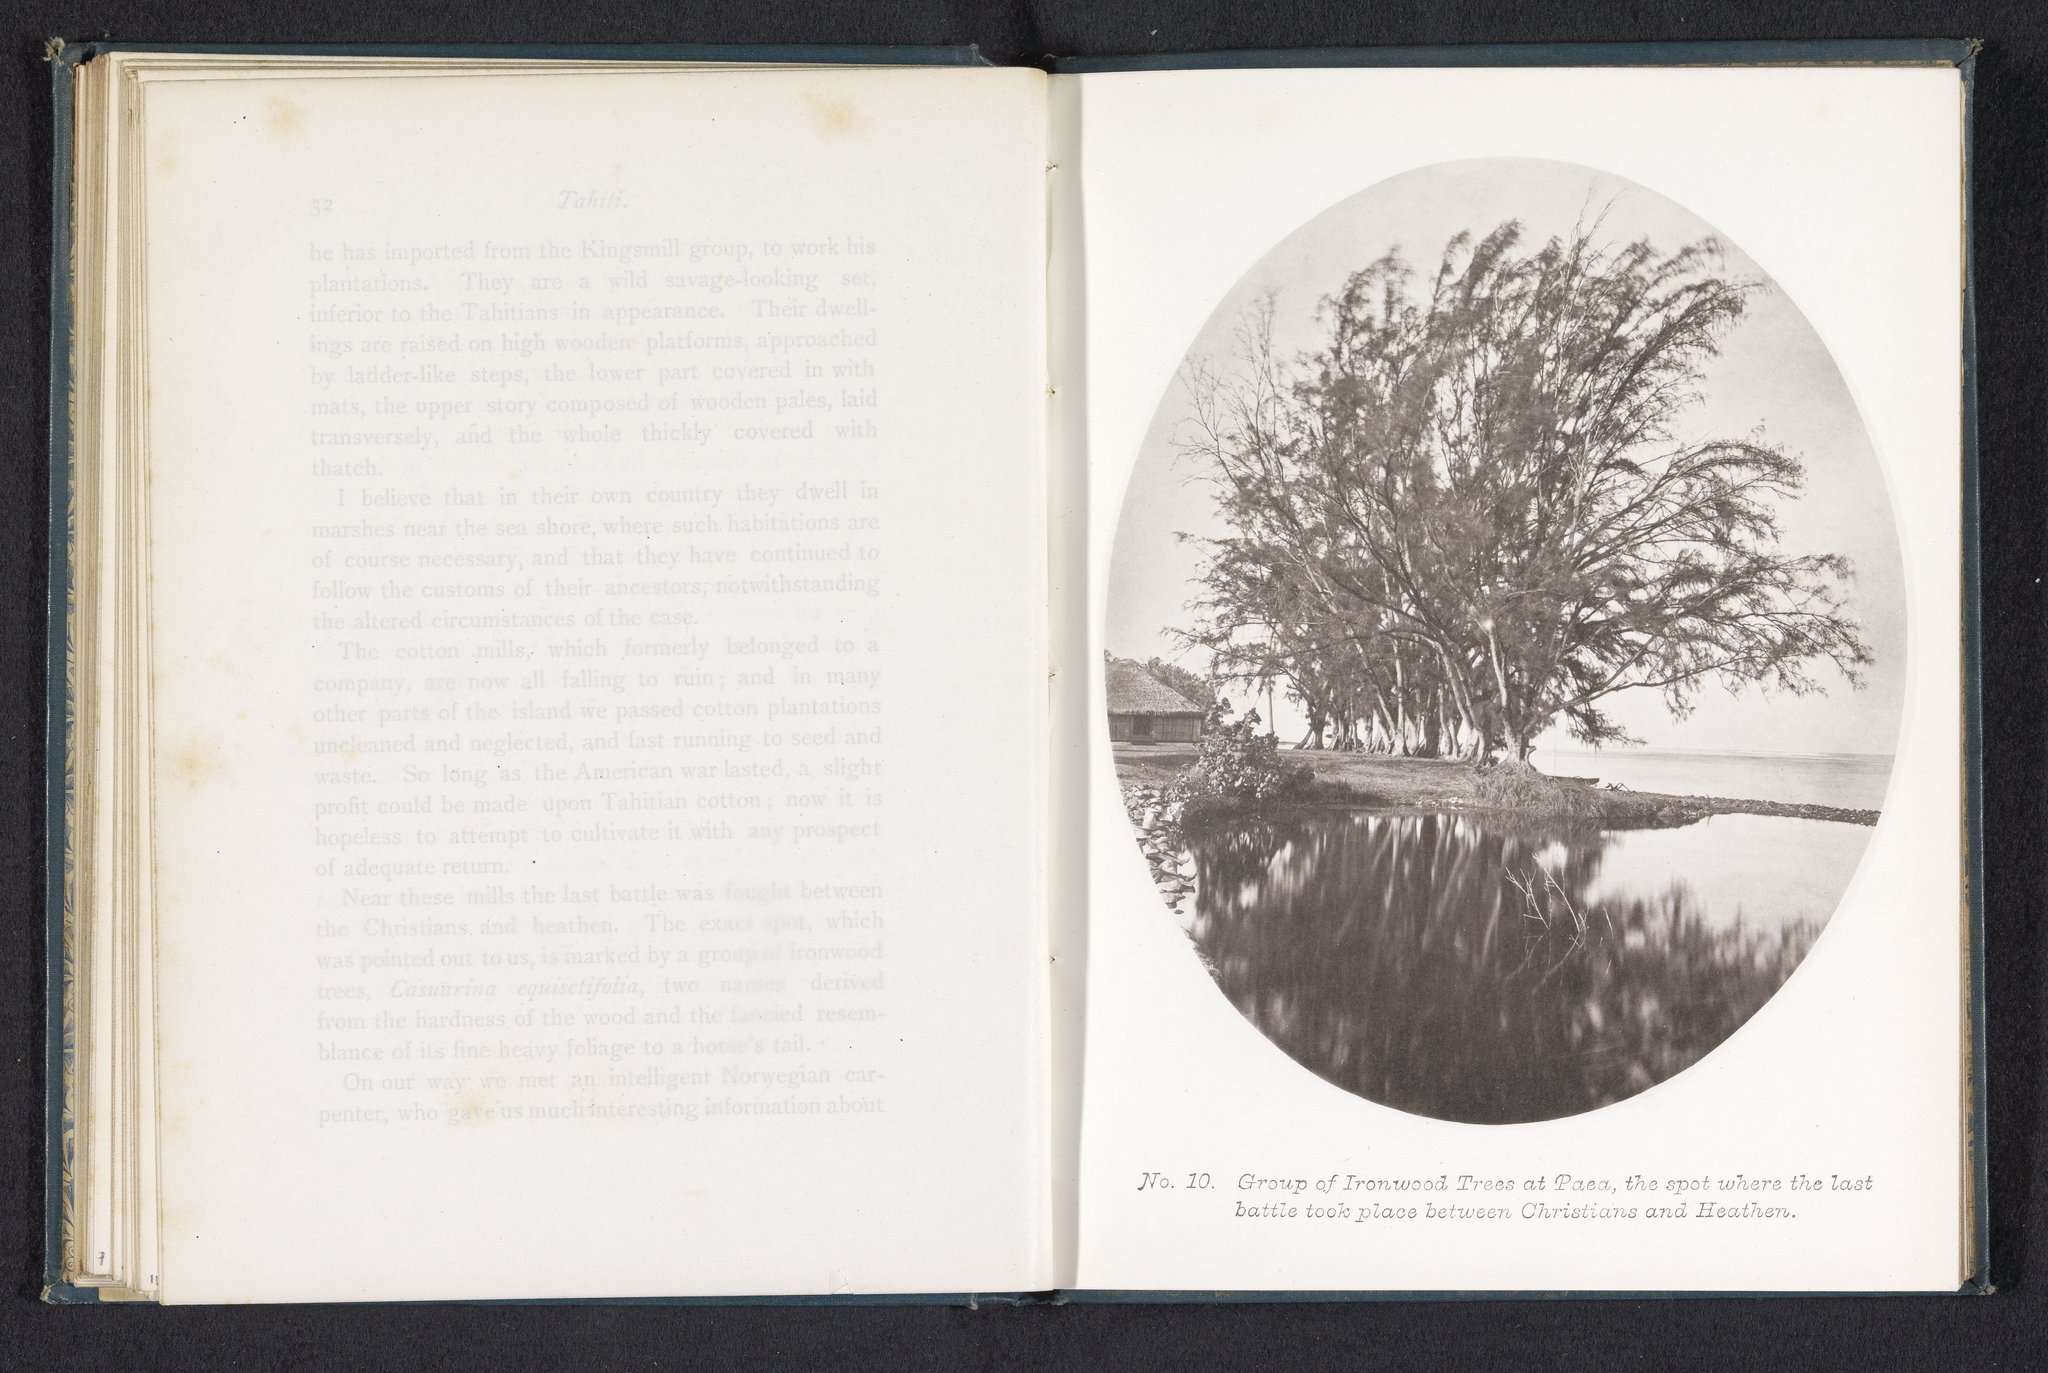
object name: page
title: Gezicht op een rij bomen in Paea op Tahiti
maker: henry stuart-wortley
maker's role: fotograaf, kolonel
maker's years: 1832-1890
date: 1880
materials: paper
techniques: photograph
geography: tahiti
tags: trees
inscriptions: number: ‘No. 10.’